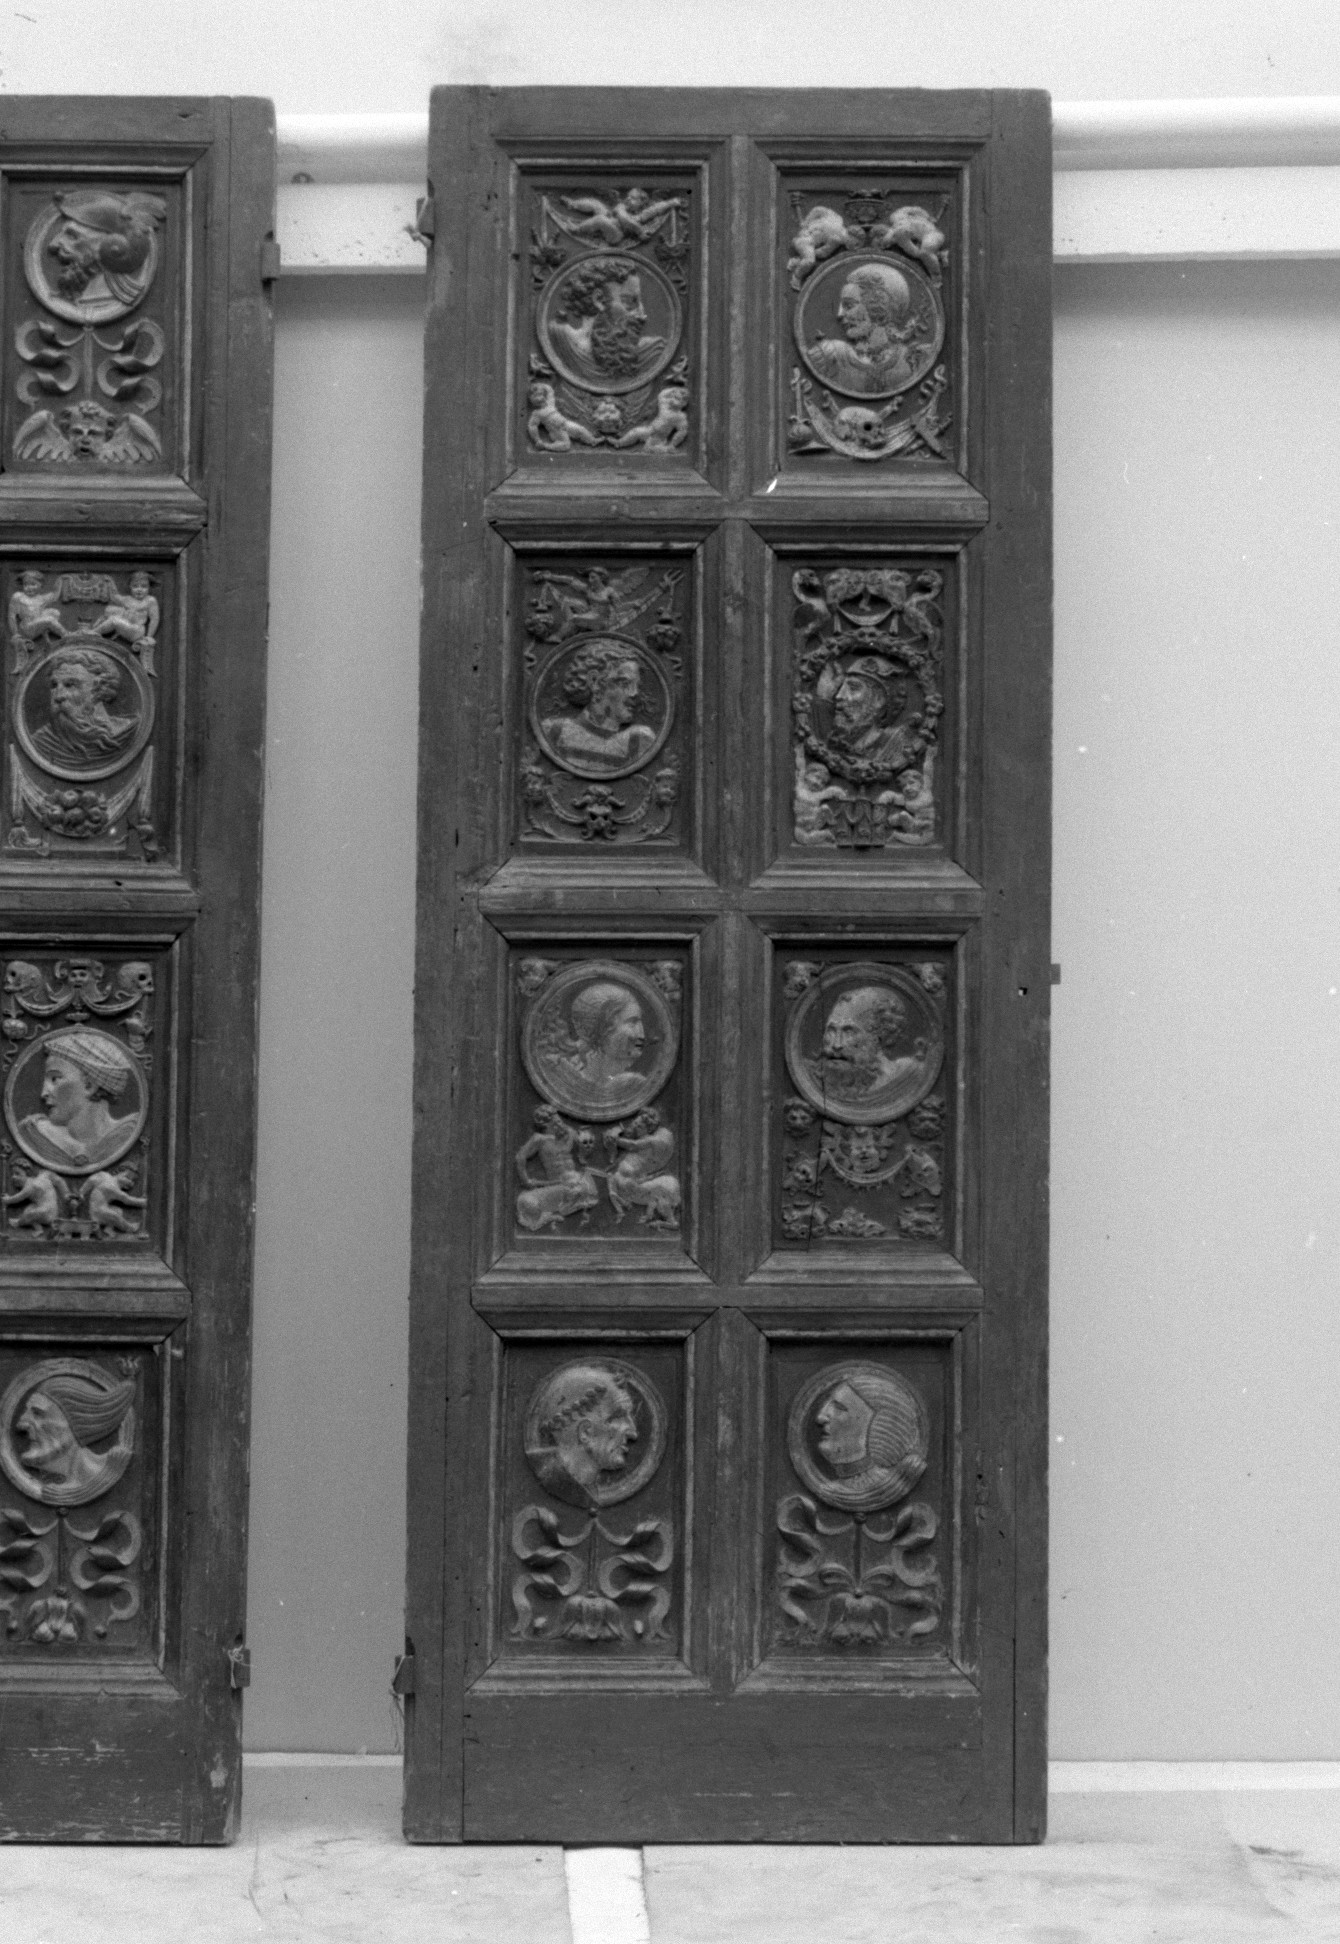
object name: door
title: Pair of doors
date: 1534-1566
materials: wood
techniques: gilding, polychrome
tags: human figures,doors,profiles